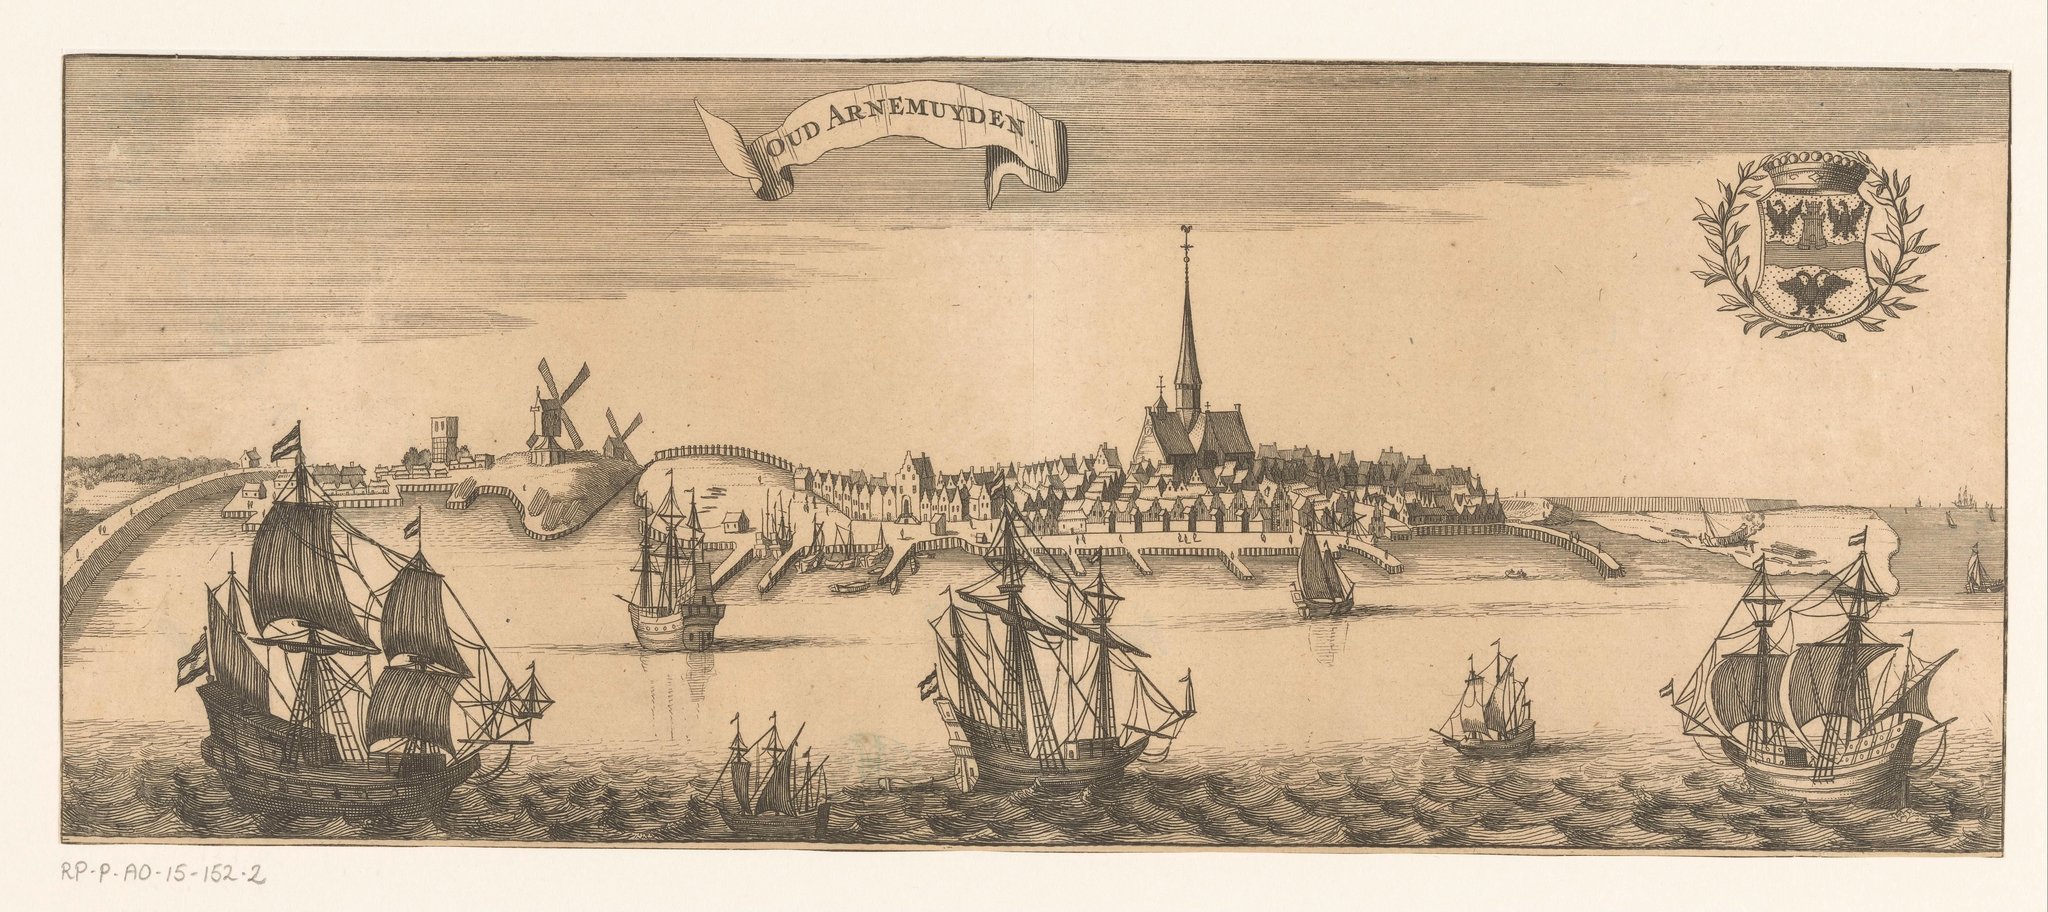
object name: book illustration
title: Gezicht op Oud-Arnemuiden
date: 1696-1728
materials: paper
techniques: engraving, etching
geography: middelburg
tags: coat of arms (as symbol of the state, etc.) (+ city; municipal), church (exterior), prospect of city, town panorama, silhouette of city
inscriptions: collector's mark: Lugt 195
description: Oorspronkelijk van één plaat gedrukt met één andere voorstelling (zie RP-P-AO-15-152-3). Prent in zijn geheel verschenen in een aantal publicaties, zie hieronder. Doordat deze prent binnen de plaatrand is afgesneden kan de staat niet precies bepaald worden. Eerste bekende staat van hele prent is een proefdruk, zie RP-P-AO-15-152-1. Tweede bekende staat van hele prent (rechtsboven genummerd) ook gebruikt in: Smallegange, Mattheus. Nieuwe Cronyk van Zeeland (…). Middelburg en Amsterdam: Johannes Meertens en Abraham van Someren, 1696. Derde bekende staat van hele prent (geen nummering rechtsboven) ook gebruikt in: Heussen, Hugo Franciscus van. Oudheden en gestichten van Zeeland (…). 2 delen. Leiden: Christiaan Vermey, 1722, dl. 1. En in: Aa, Pieter van der. La galerie agreable du monde (...). 66 delen. Leiden: Pieter van der Aa, 1728, dl. 21.